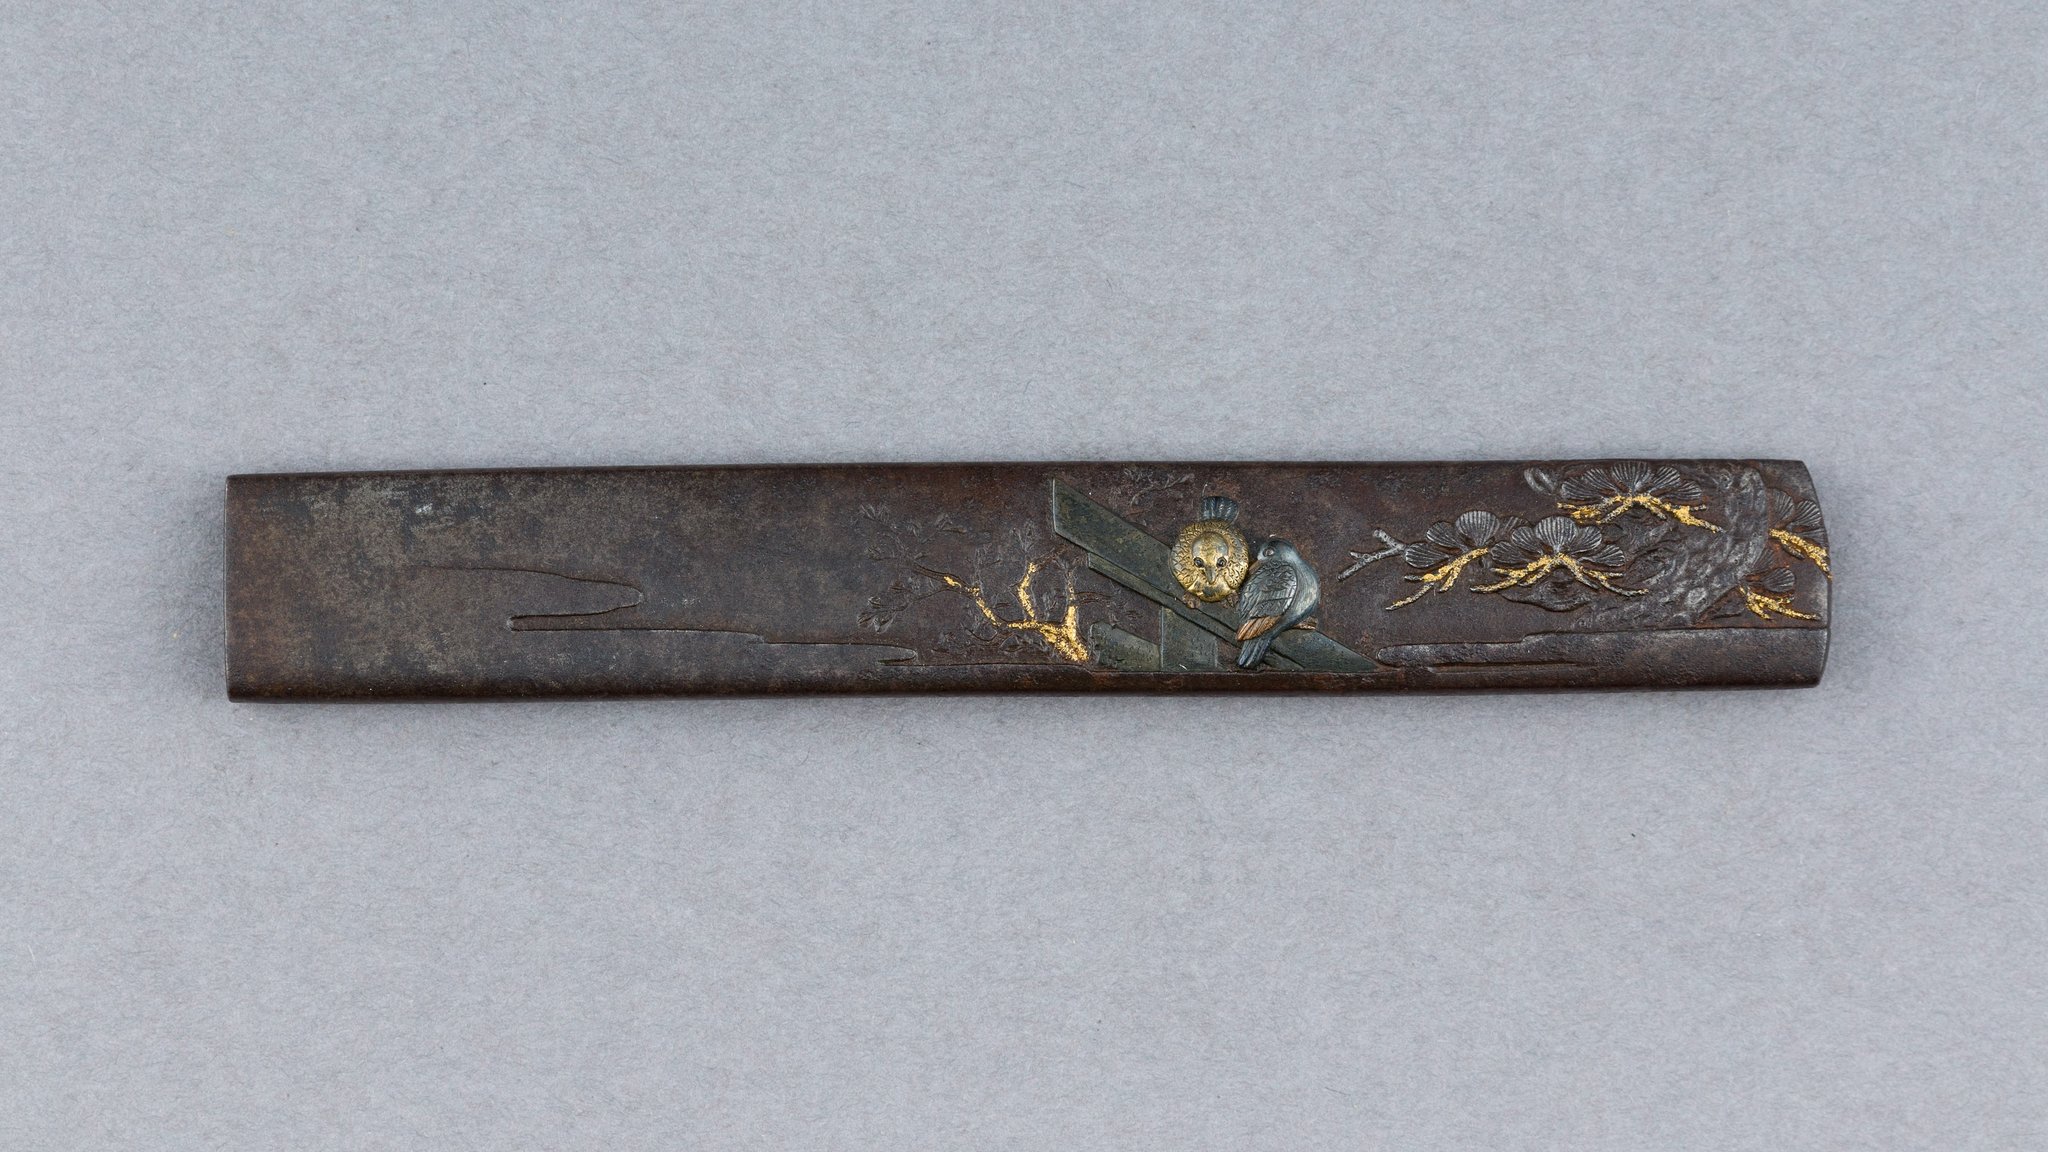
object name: knife handle kozuka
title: Knife Handle (Kozuka)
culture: japanese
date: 1845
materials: silver alloy, gold, iron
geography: japan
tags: birds